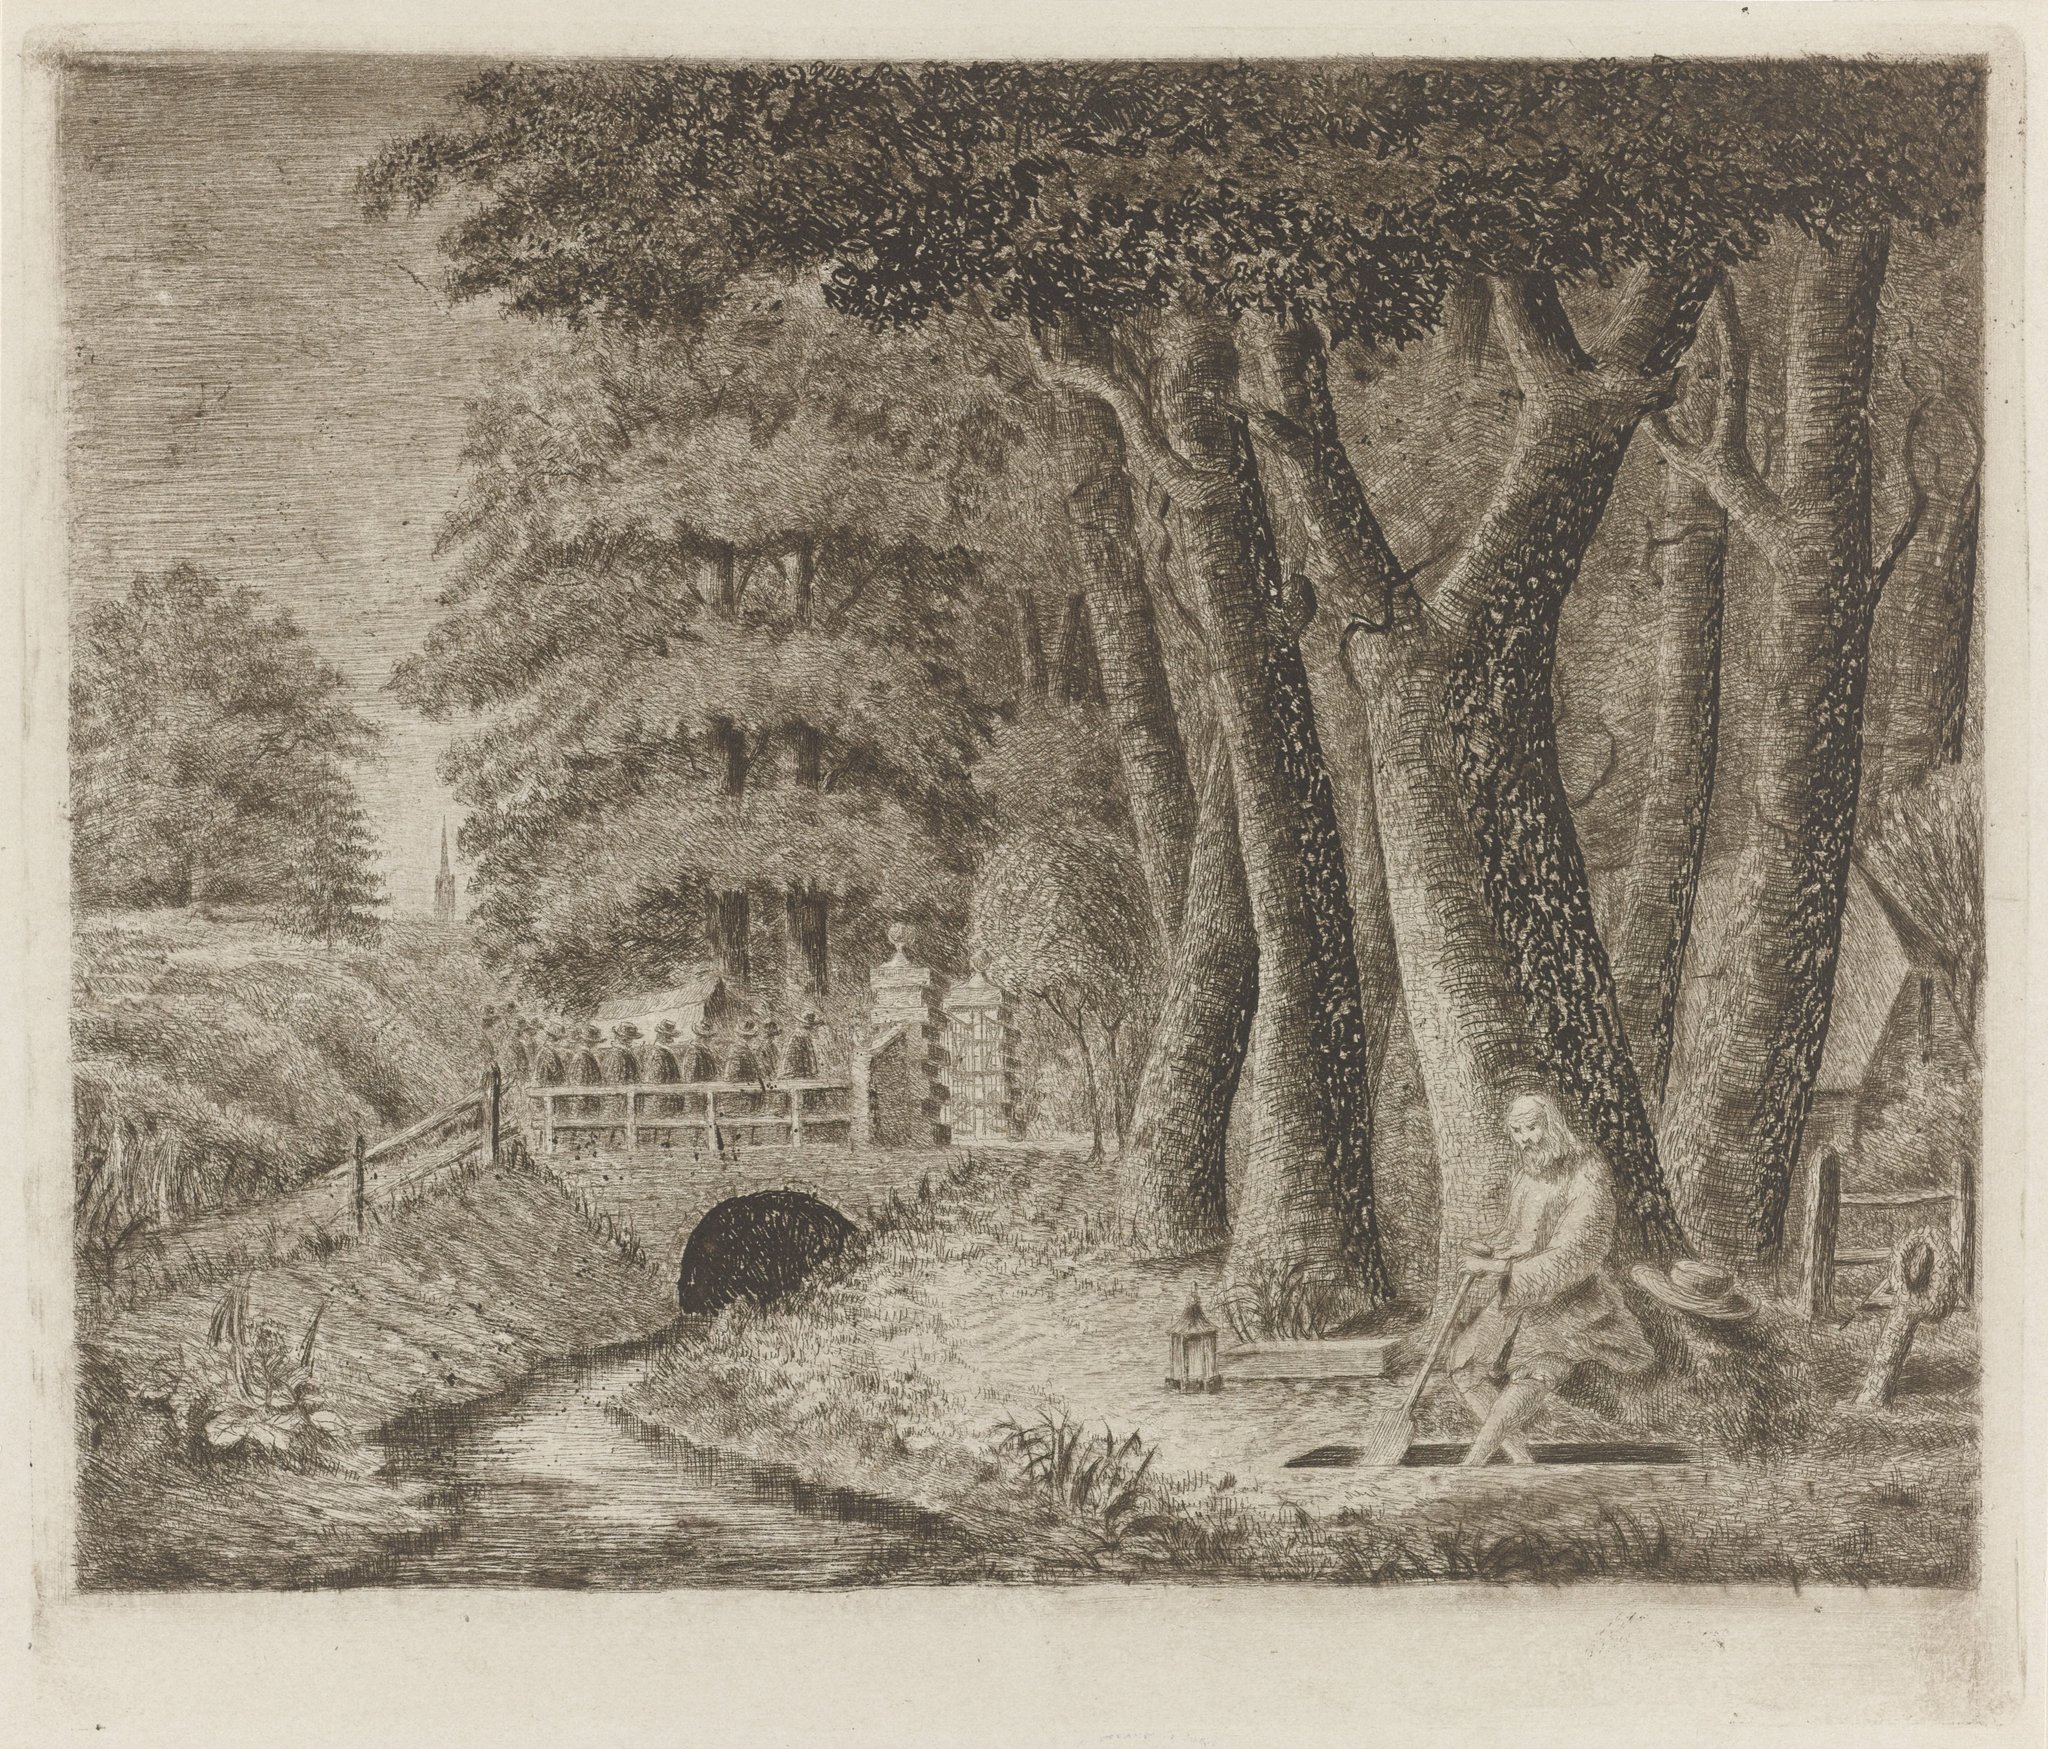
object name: print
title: Grafdelver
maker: eberhard cornelis rahms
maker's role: print maker, publisher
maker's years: 1823-1907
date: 1862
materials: paper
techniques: drypoint, etching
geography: oudewater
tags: cortege, funeral procession, grave digger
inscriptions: collector's mark: Lugt 2228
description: Aan de waterkant, onder geboomte, graaft een doodgraver een graf. Op de achtergrond een brug met de begrafenisstoet met de kist.